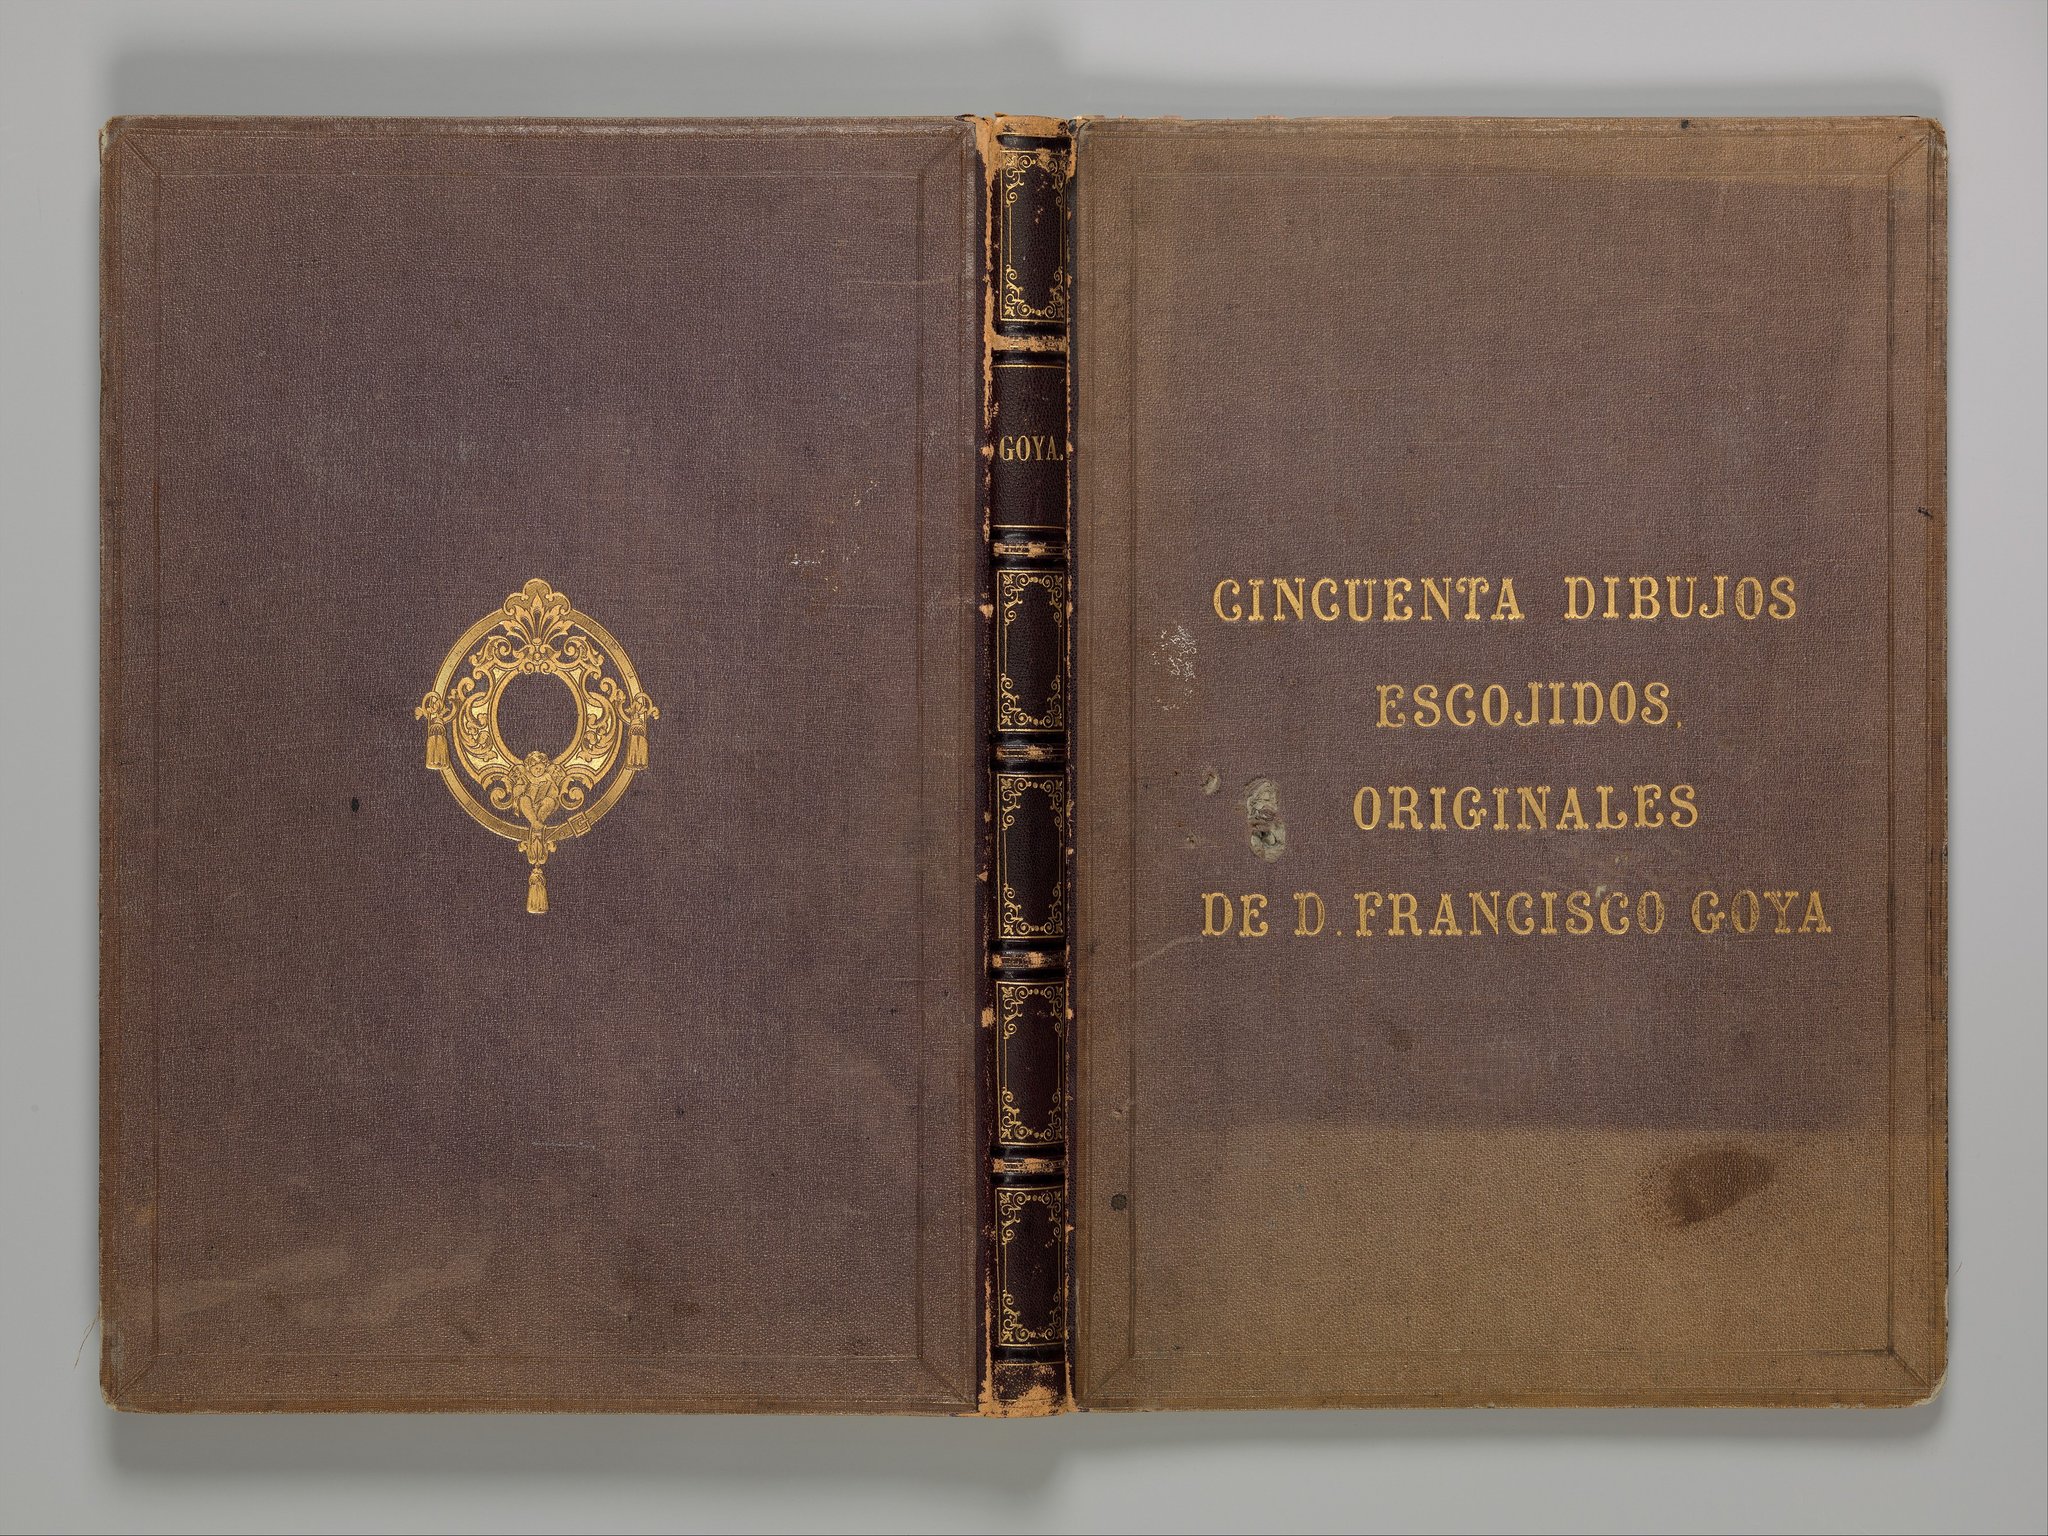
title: Empty Album that formerly housed a group of 50 Goya drawings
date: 1866-1868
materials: leather, paper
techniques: drawing